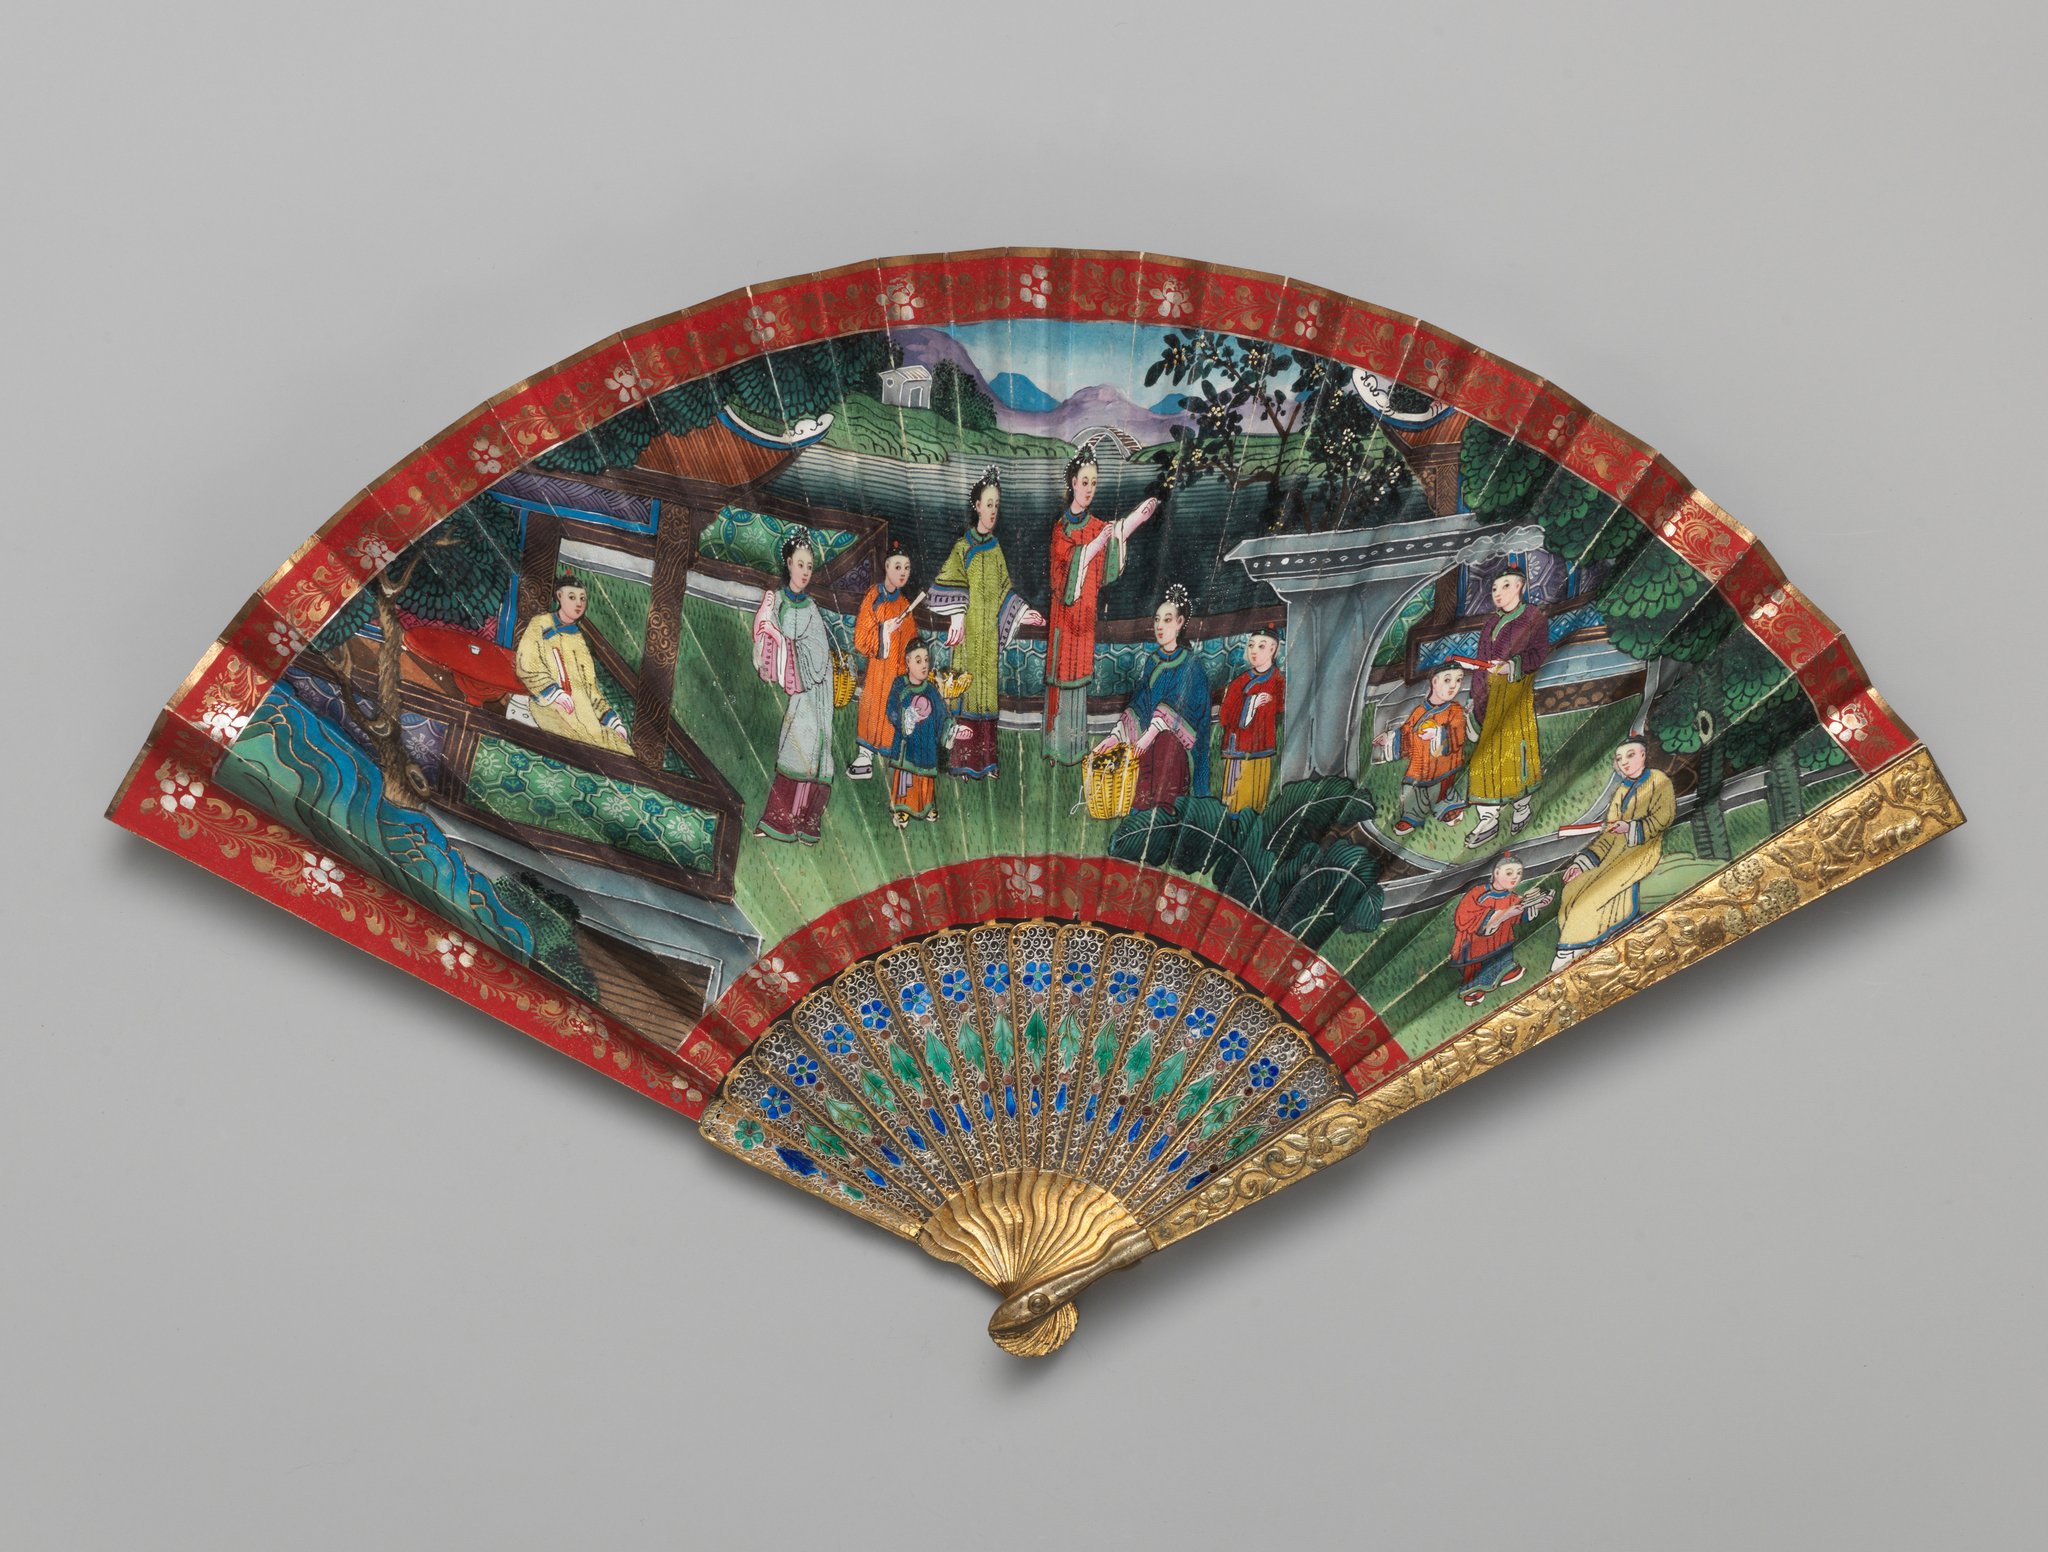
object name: fan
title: Folding Fan with Scene of Figures in a Courtyard Garden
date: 1801-1900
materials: brass, paper, silk, silver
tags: birds,children,women